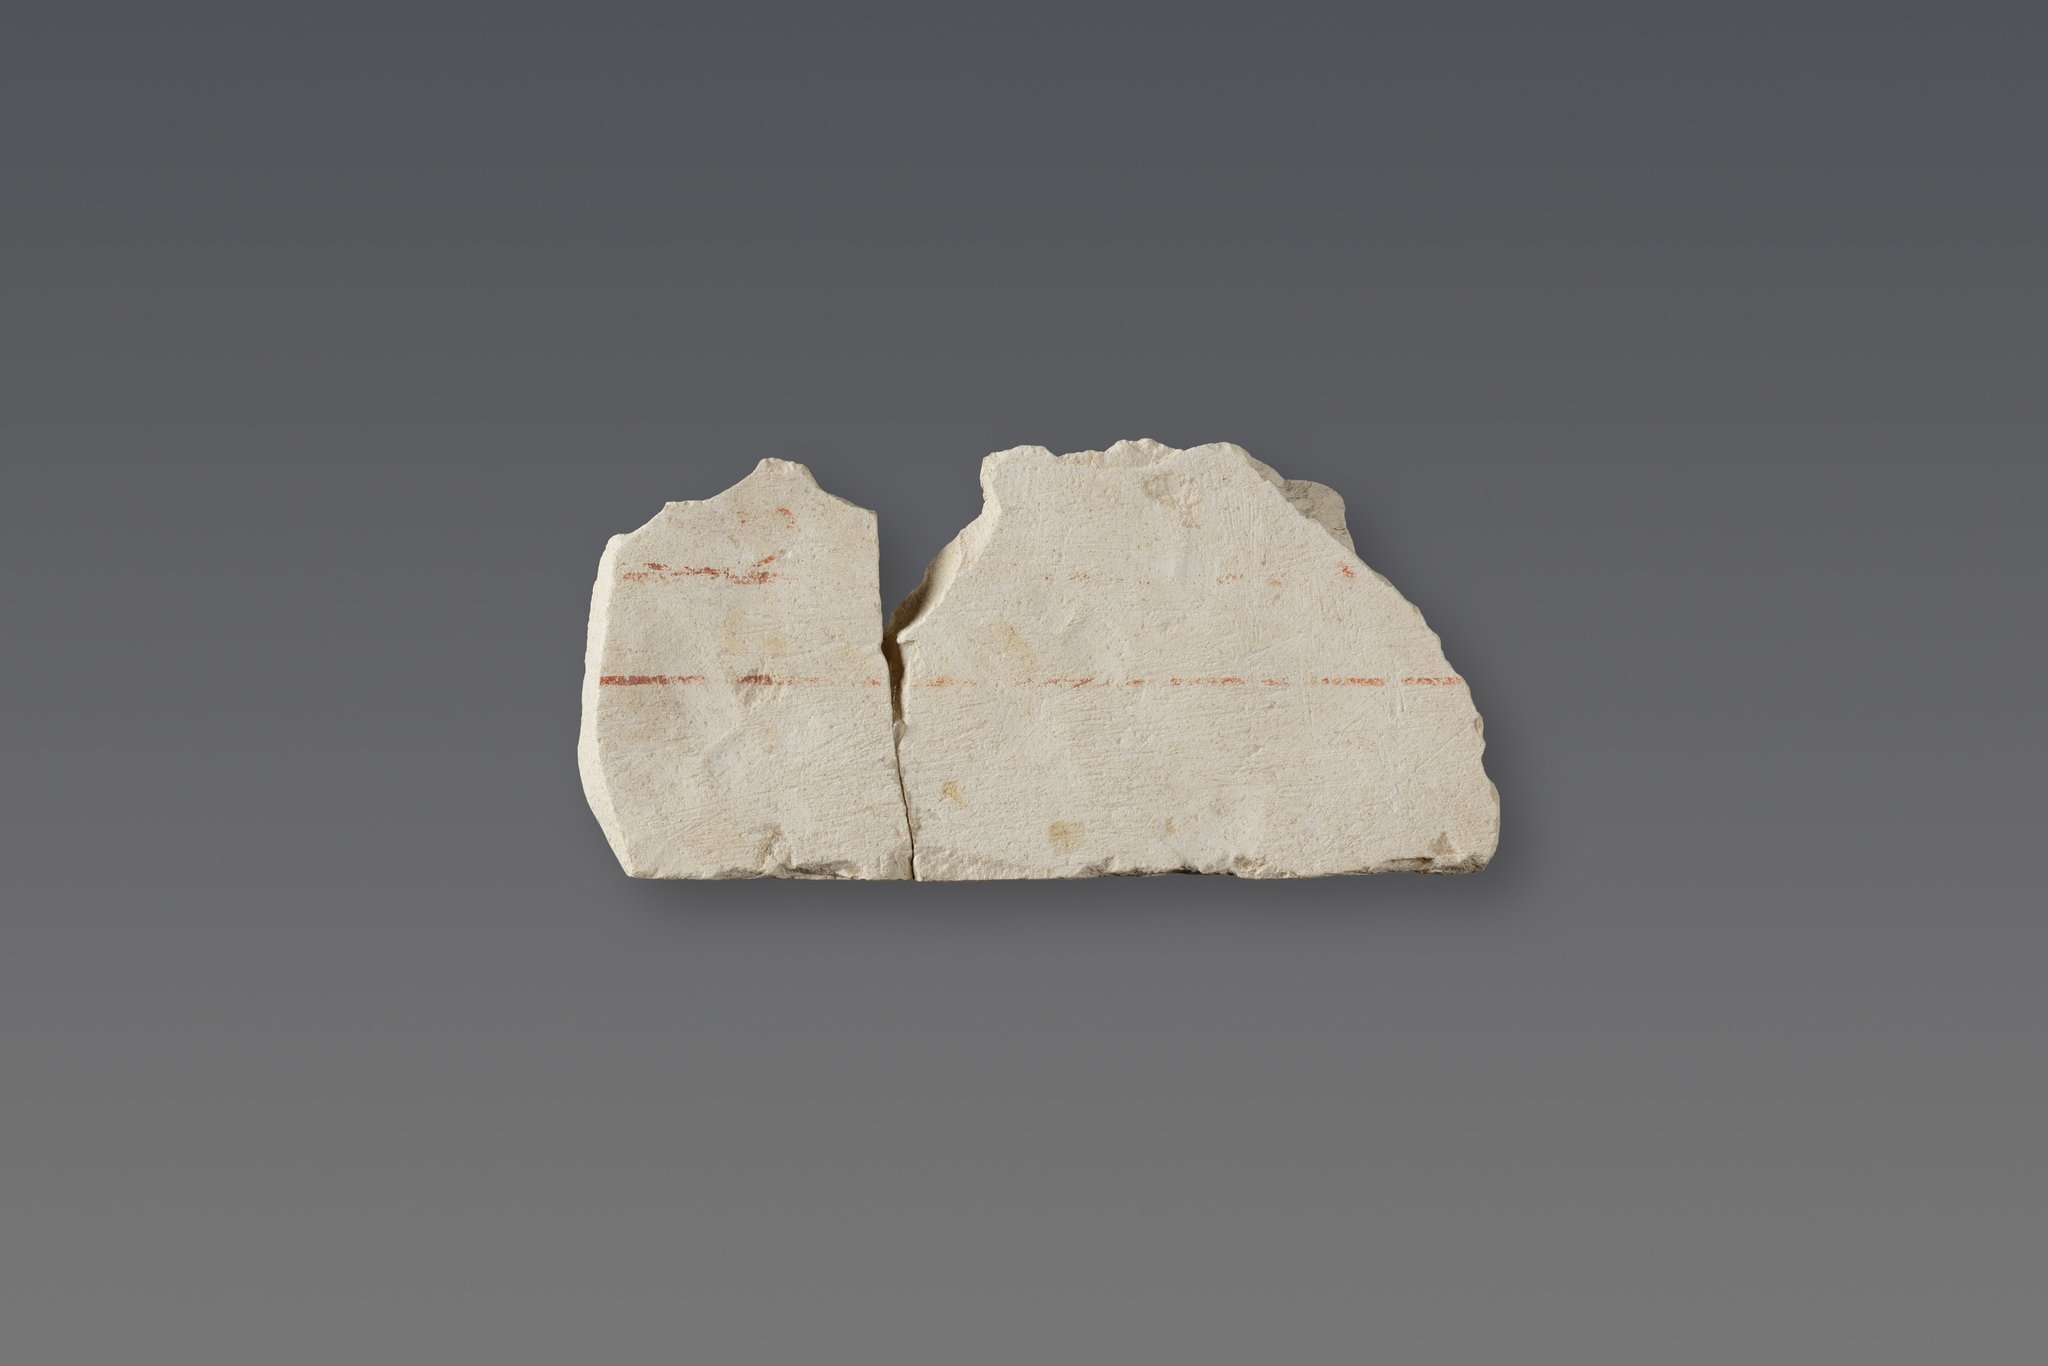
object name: relief drawing, sebeknakhte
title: Preliminary drawing for a relief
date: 2124-1504 BCE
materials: limestone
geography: egypt